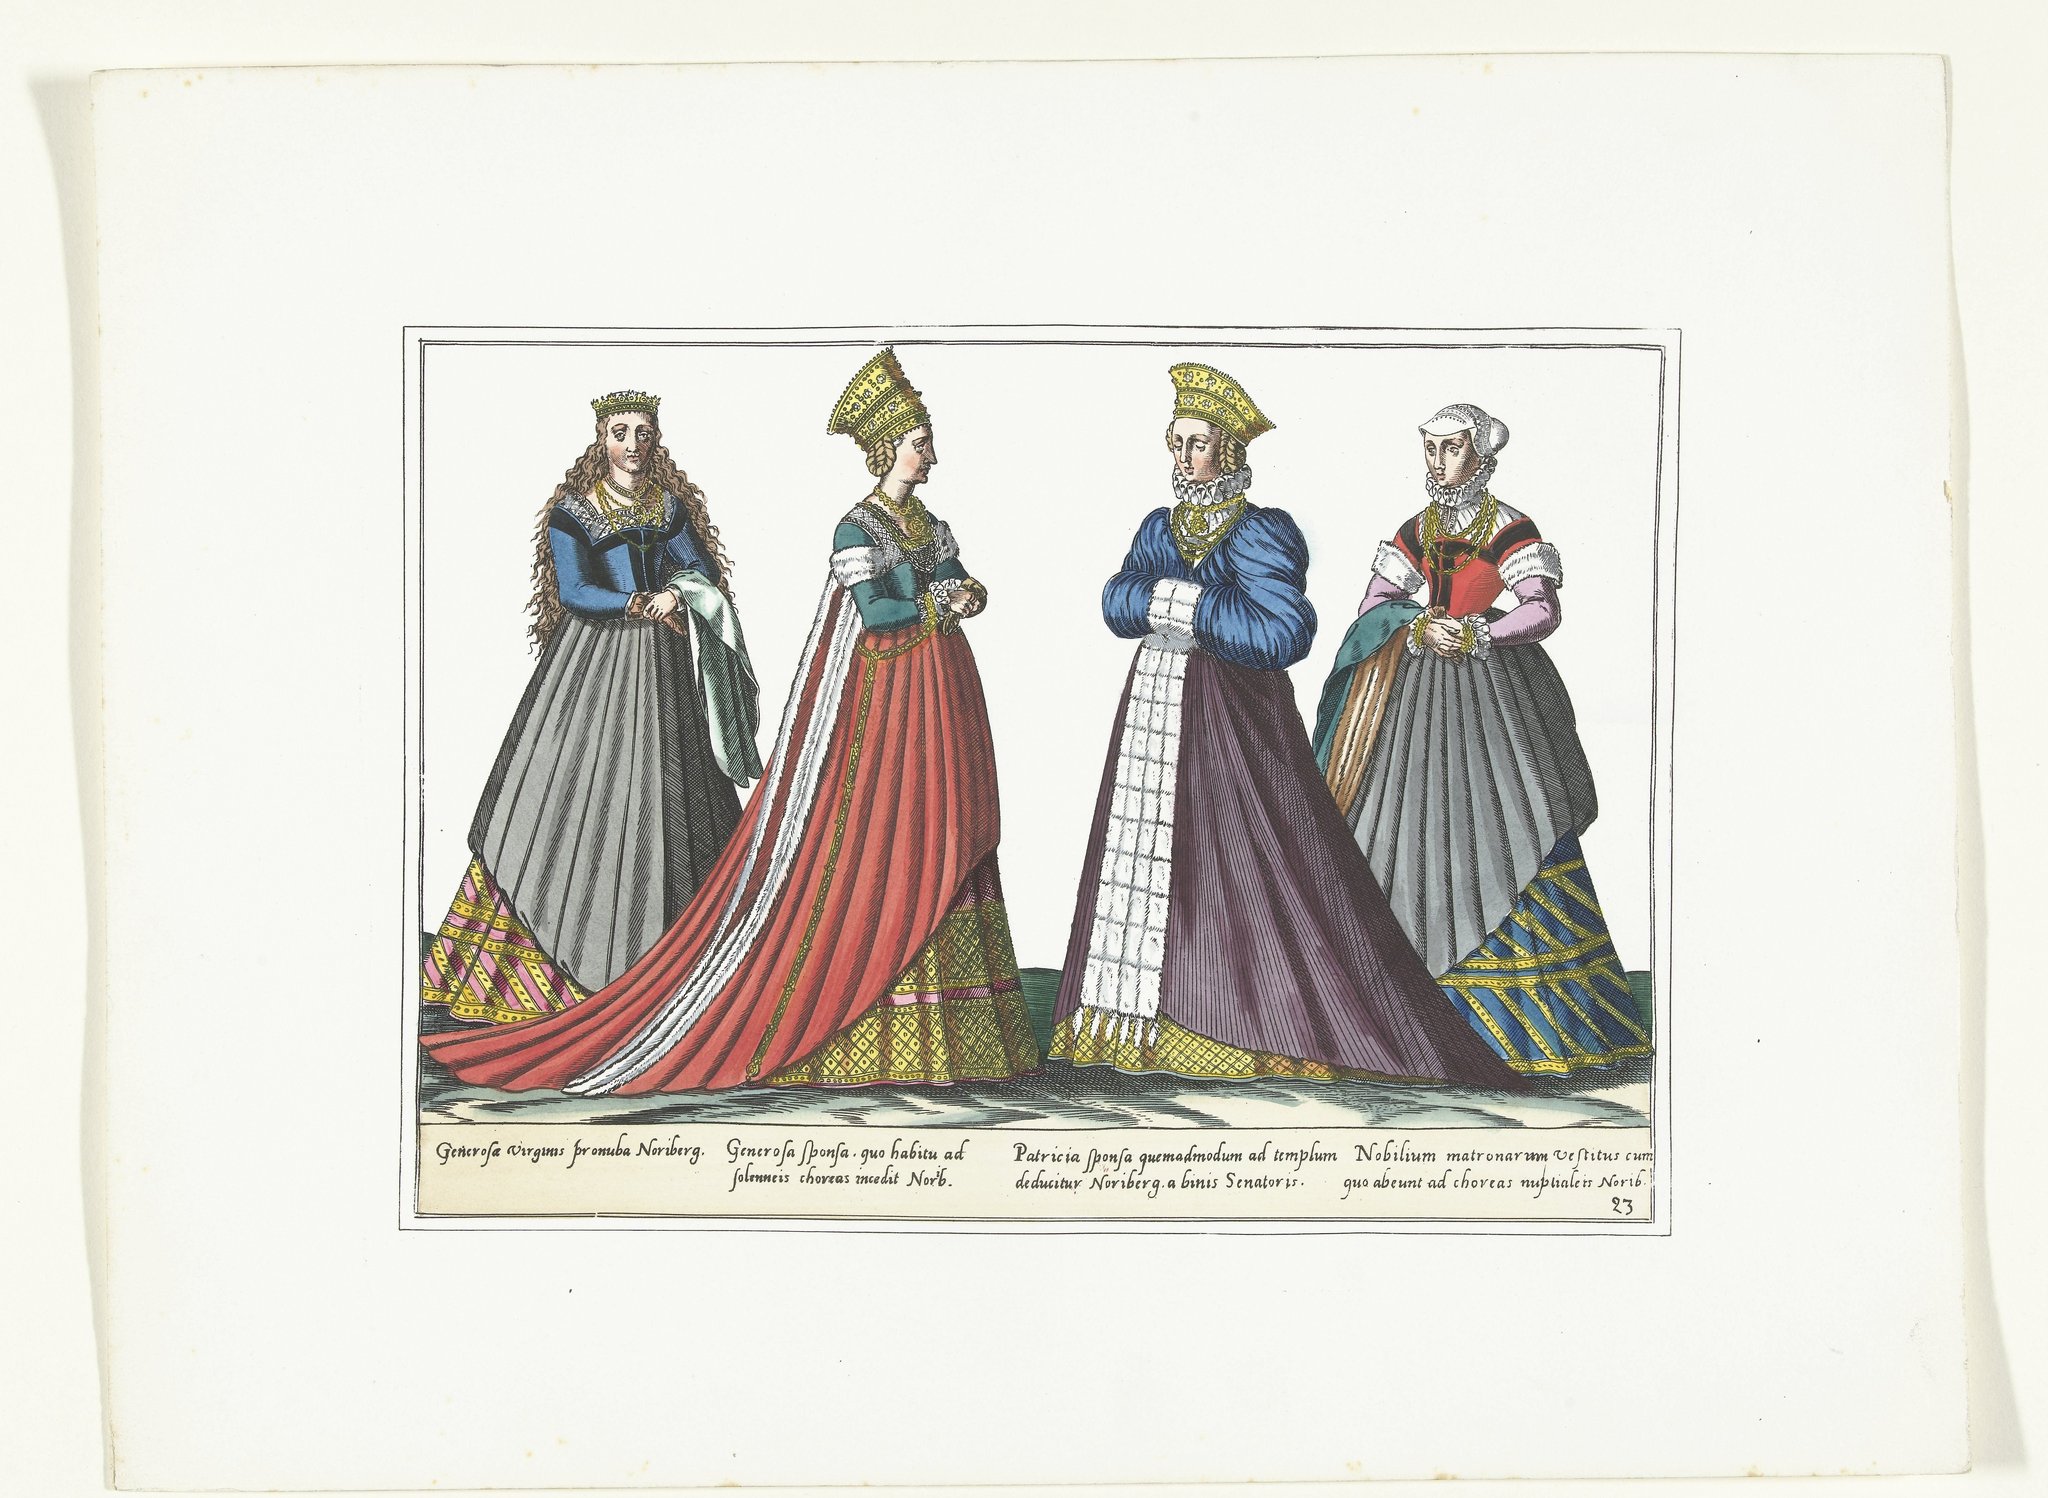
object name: print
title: Costumes Allemands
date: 1872-1875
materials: paper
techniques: hand coloring, printing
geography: brussels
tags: clothes, costume (+ women's clothes)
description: Onderdeel van Costumes civils et militaires du XVIe siècle par A. de Bruyn, een selectie van prenten uit de Trachtenbuch van Abraham de Bruyn uit 1581 (Hollstein 248-306), in facsimile. Losbladig uitgegeven met titelbladen, verklaring en lijst van de platen door G.A. van Trigt te Brussel in 1875 met teksten van Auguste Schoy. In de Rijksmuseum Research Library met signatuur 34 C 43.